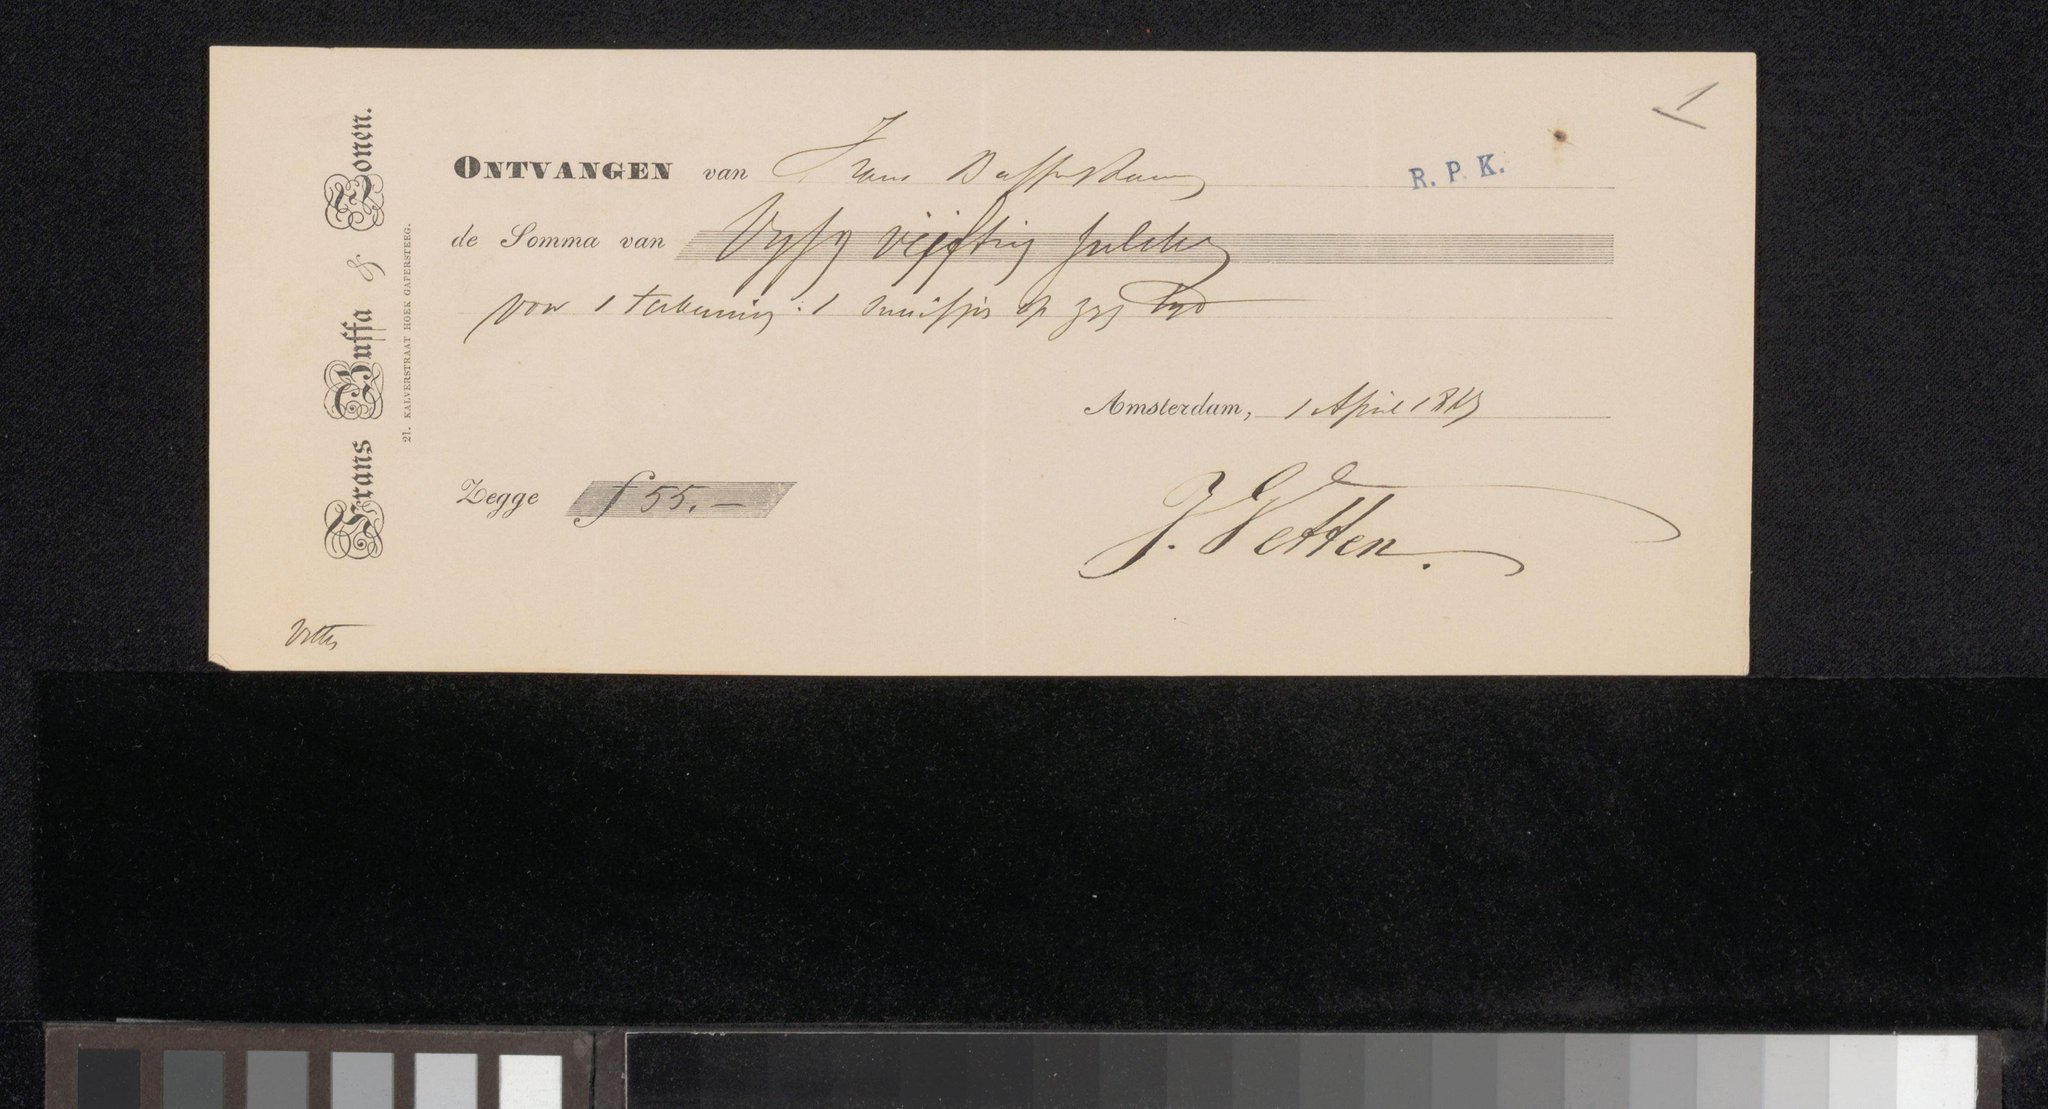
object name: ontvangstbewijs, kwitantie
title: Kwitantie voor Johannes Vetten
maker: johannes vetten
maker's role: painter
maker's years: 1827-1866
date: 1863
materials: ink, paper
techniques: pen, printing, writing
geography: amsterdam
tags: drawing, money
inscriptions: collector's mark: Lugt 2233